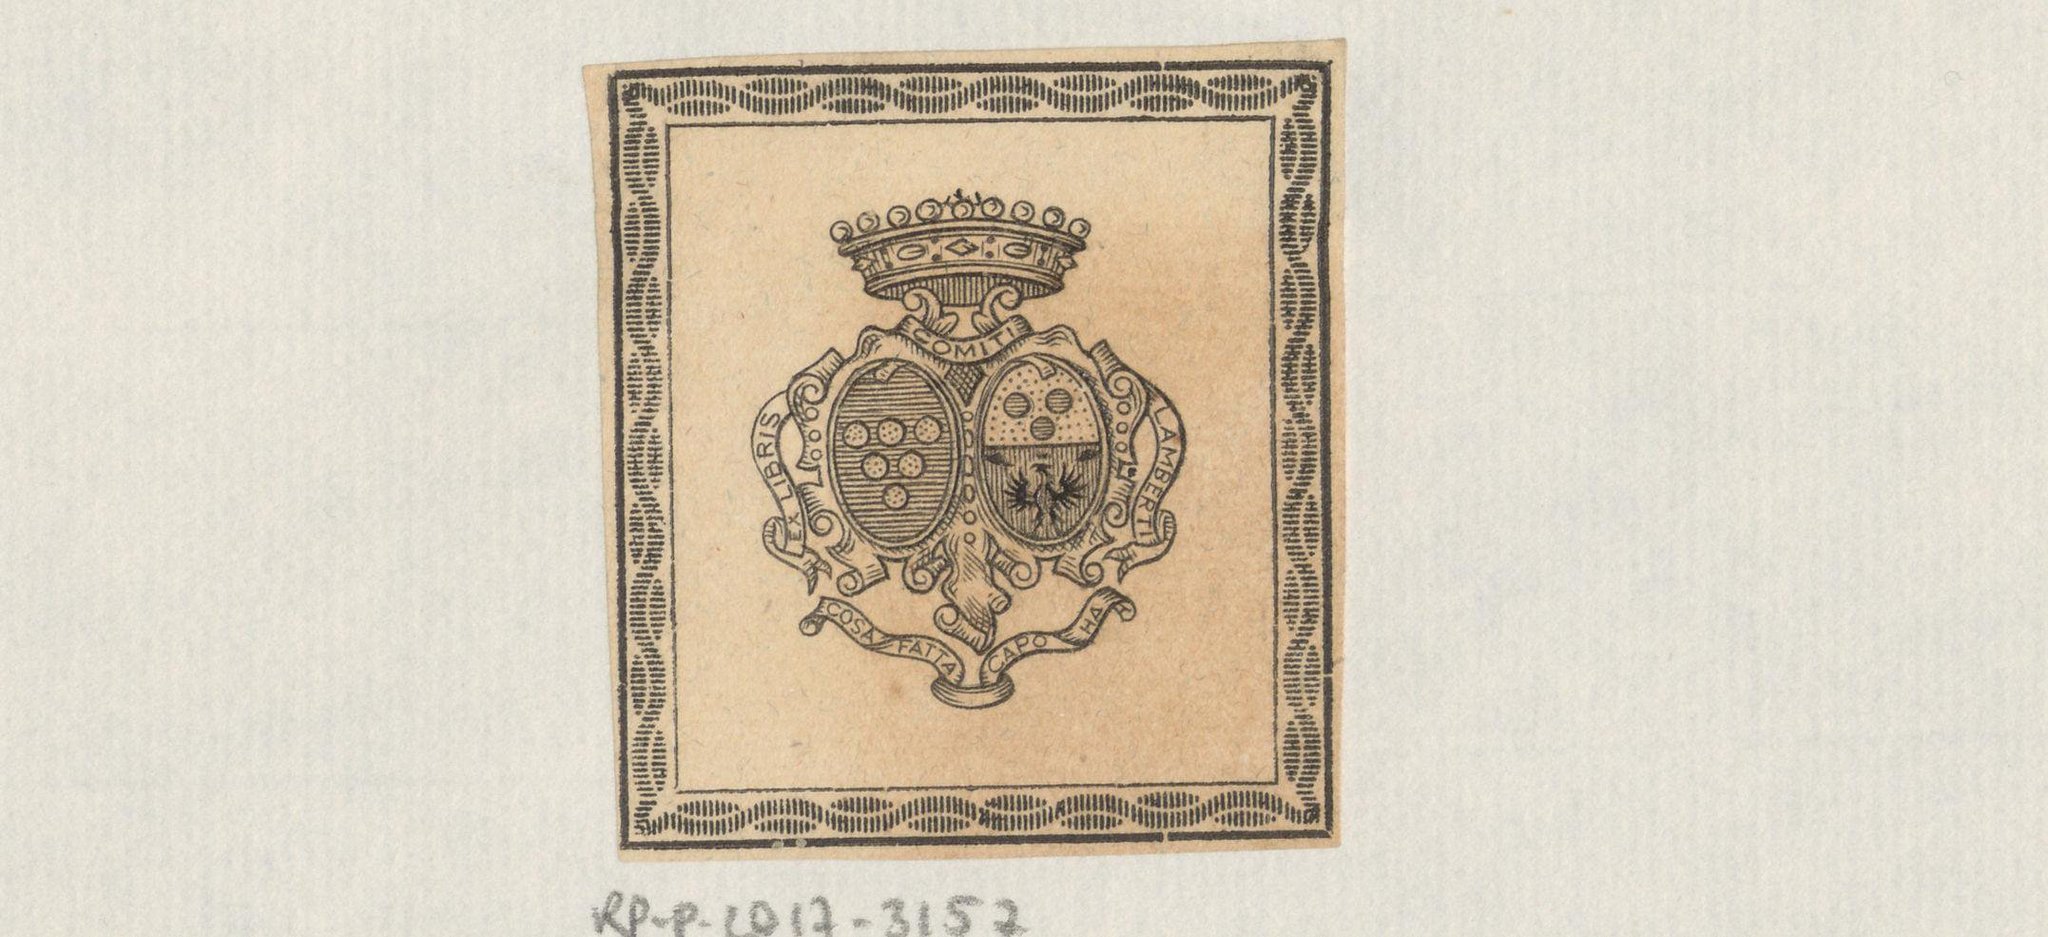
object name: bookplate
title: Cosa fatta capo ha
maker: Anonymous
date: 1850-1950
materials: paper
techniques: printing block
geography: italy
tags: armorial bearing, heraldry